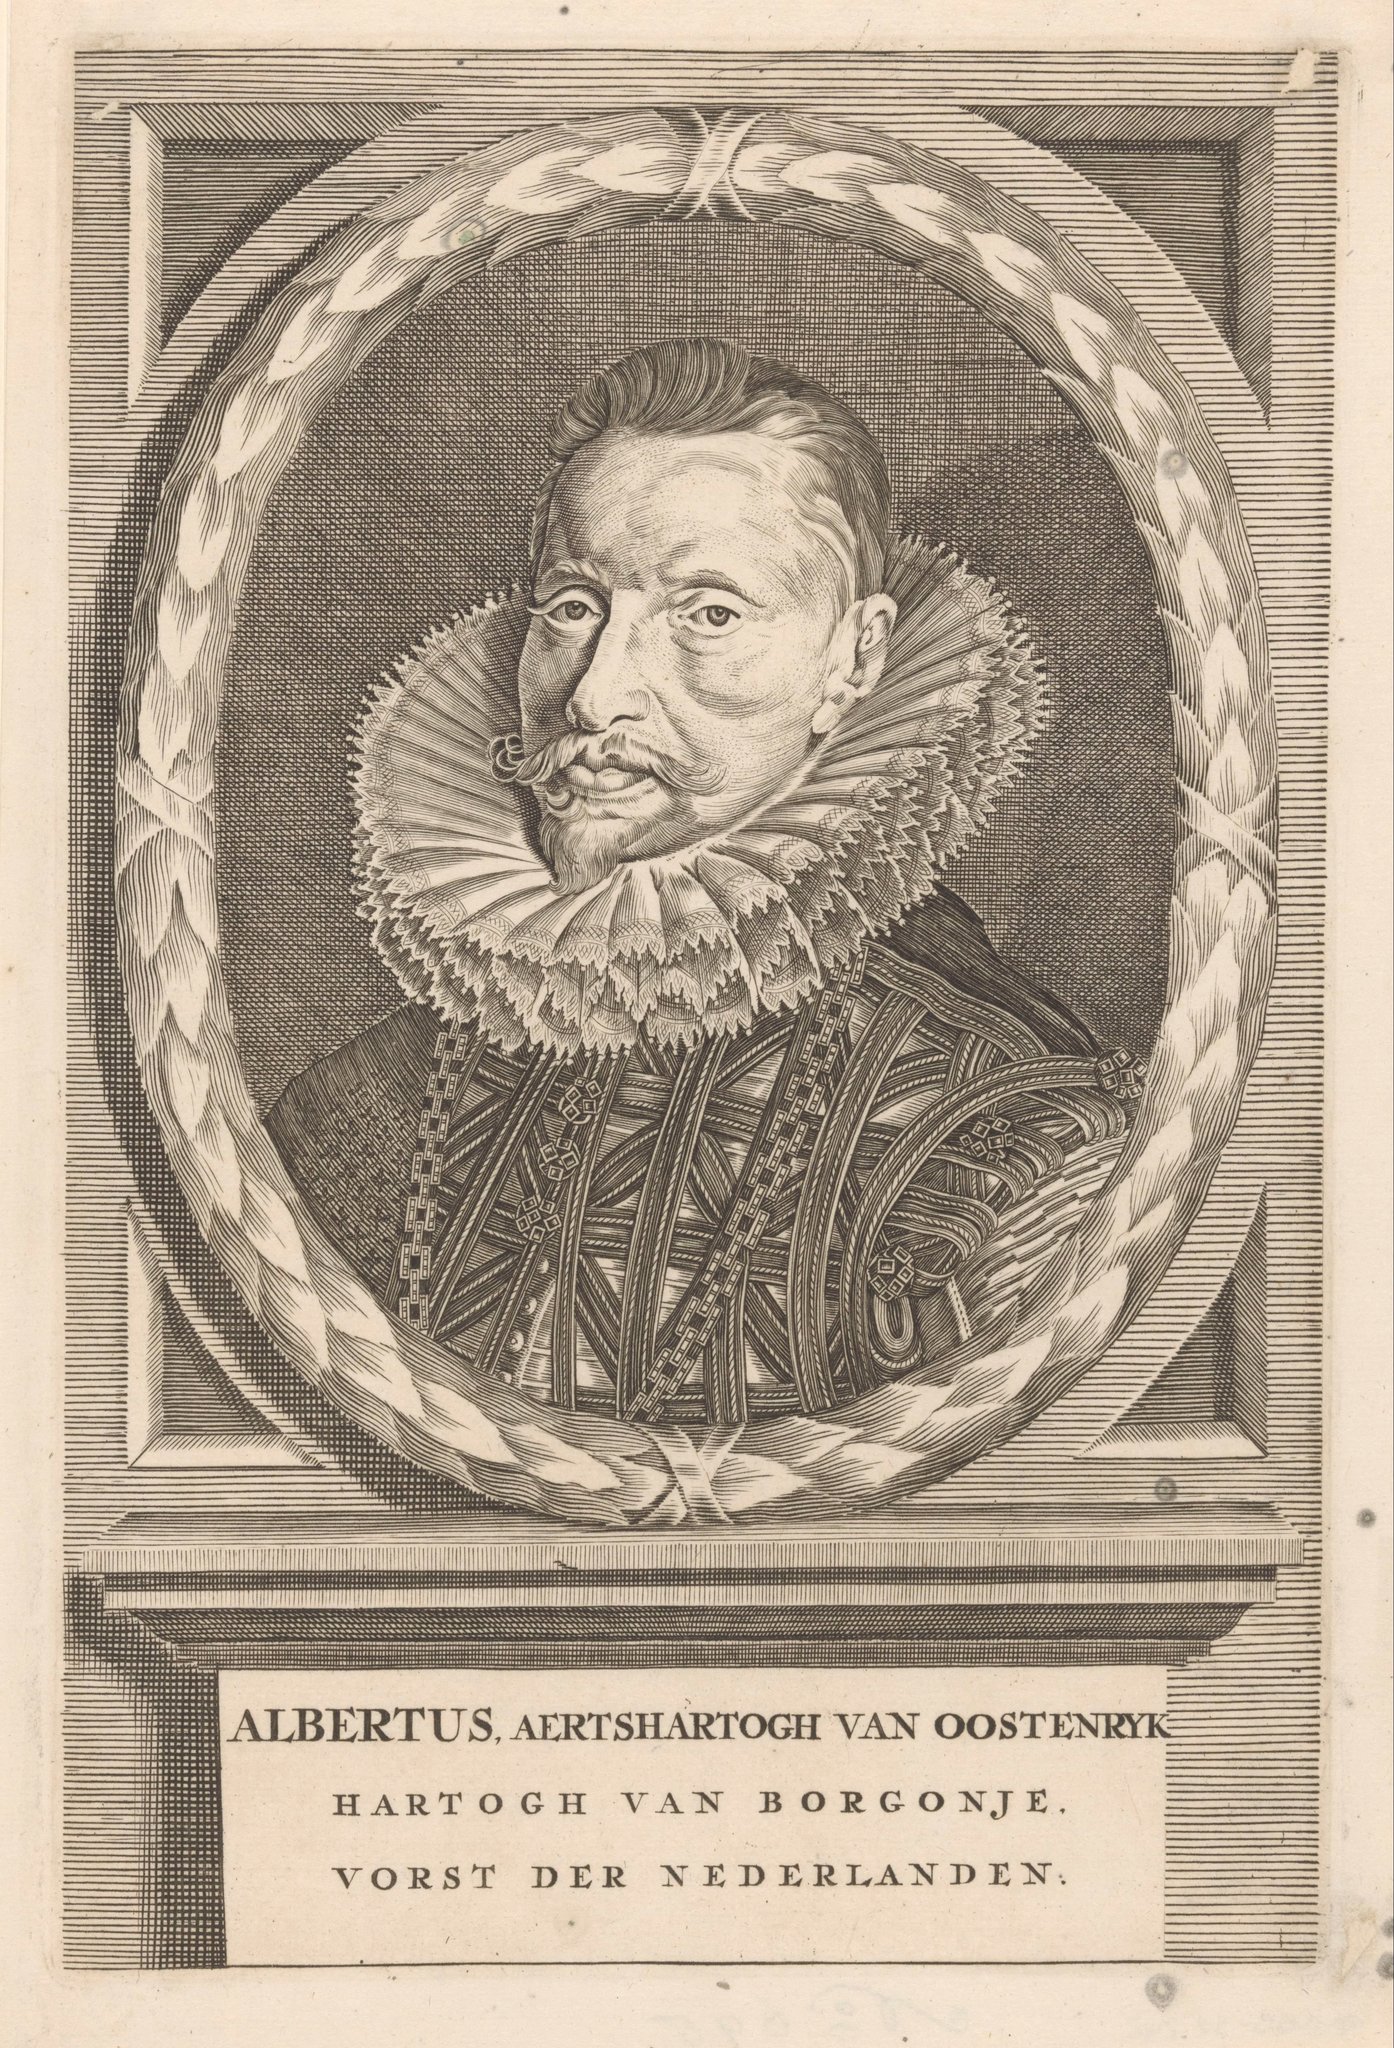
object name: print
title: Portret van Albrecht, aartshertog van Oostenrijk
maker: Anonymous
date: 1600-1699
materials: paper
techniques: engraving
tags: albrecht aartshertog van oostenrijk